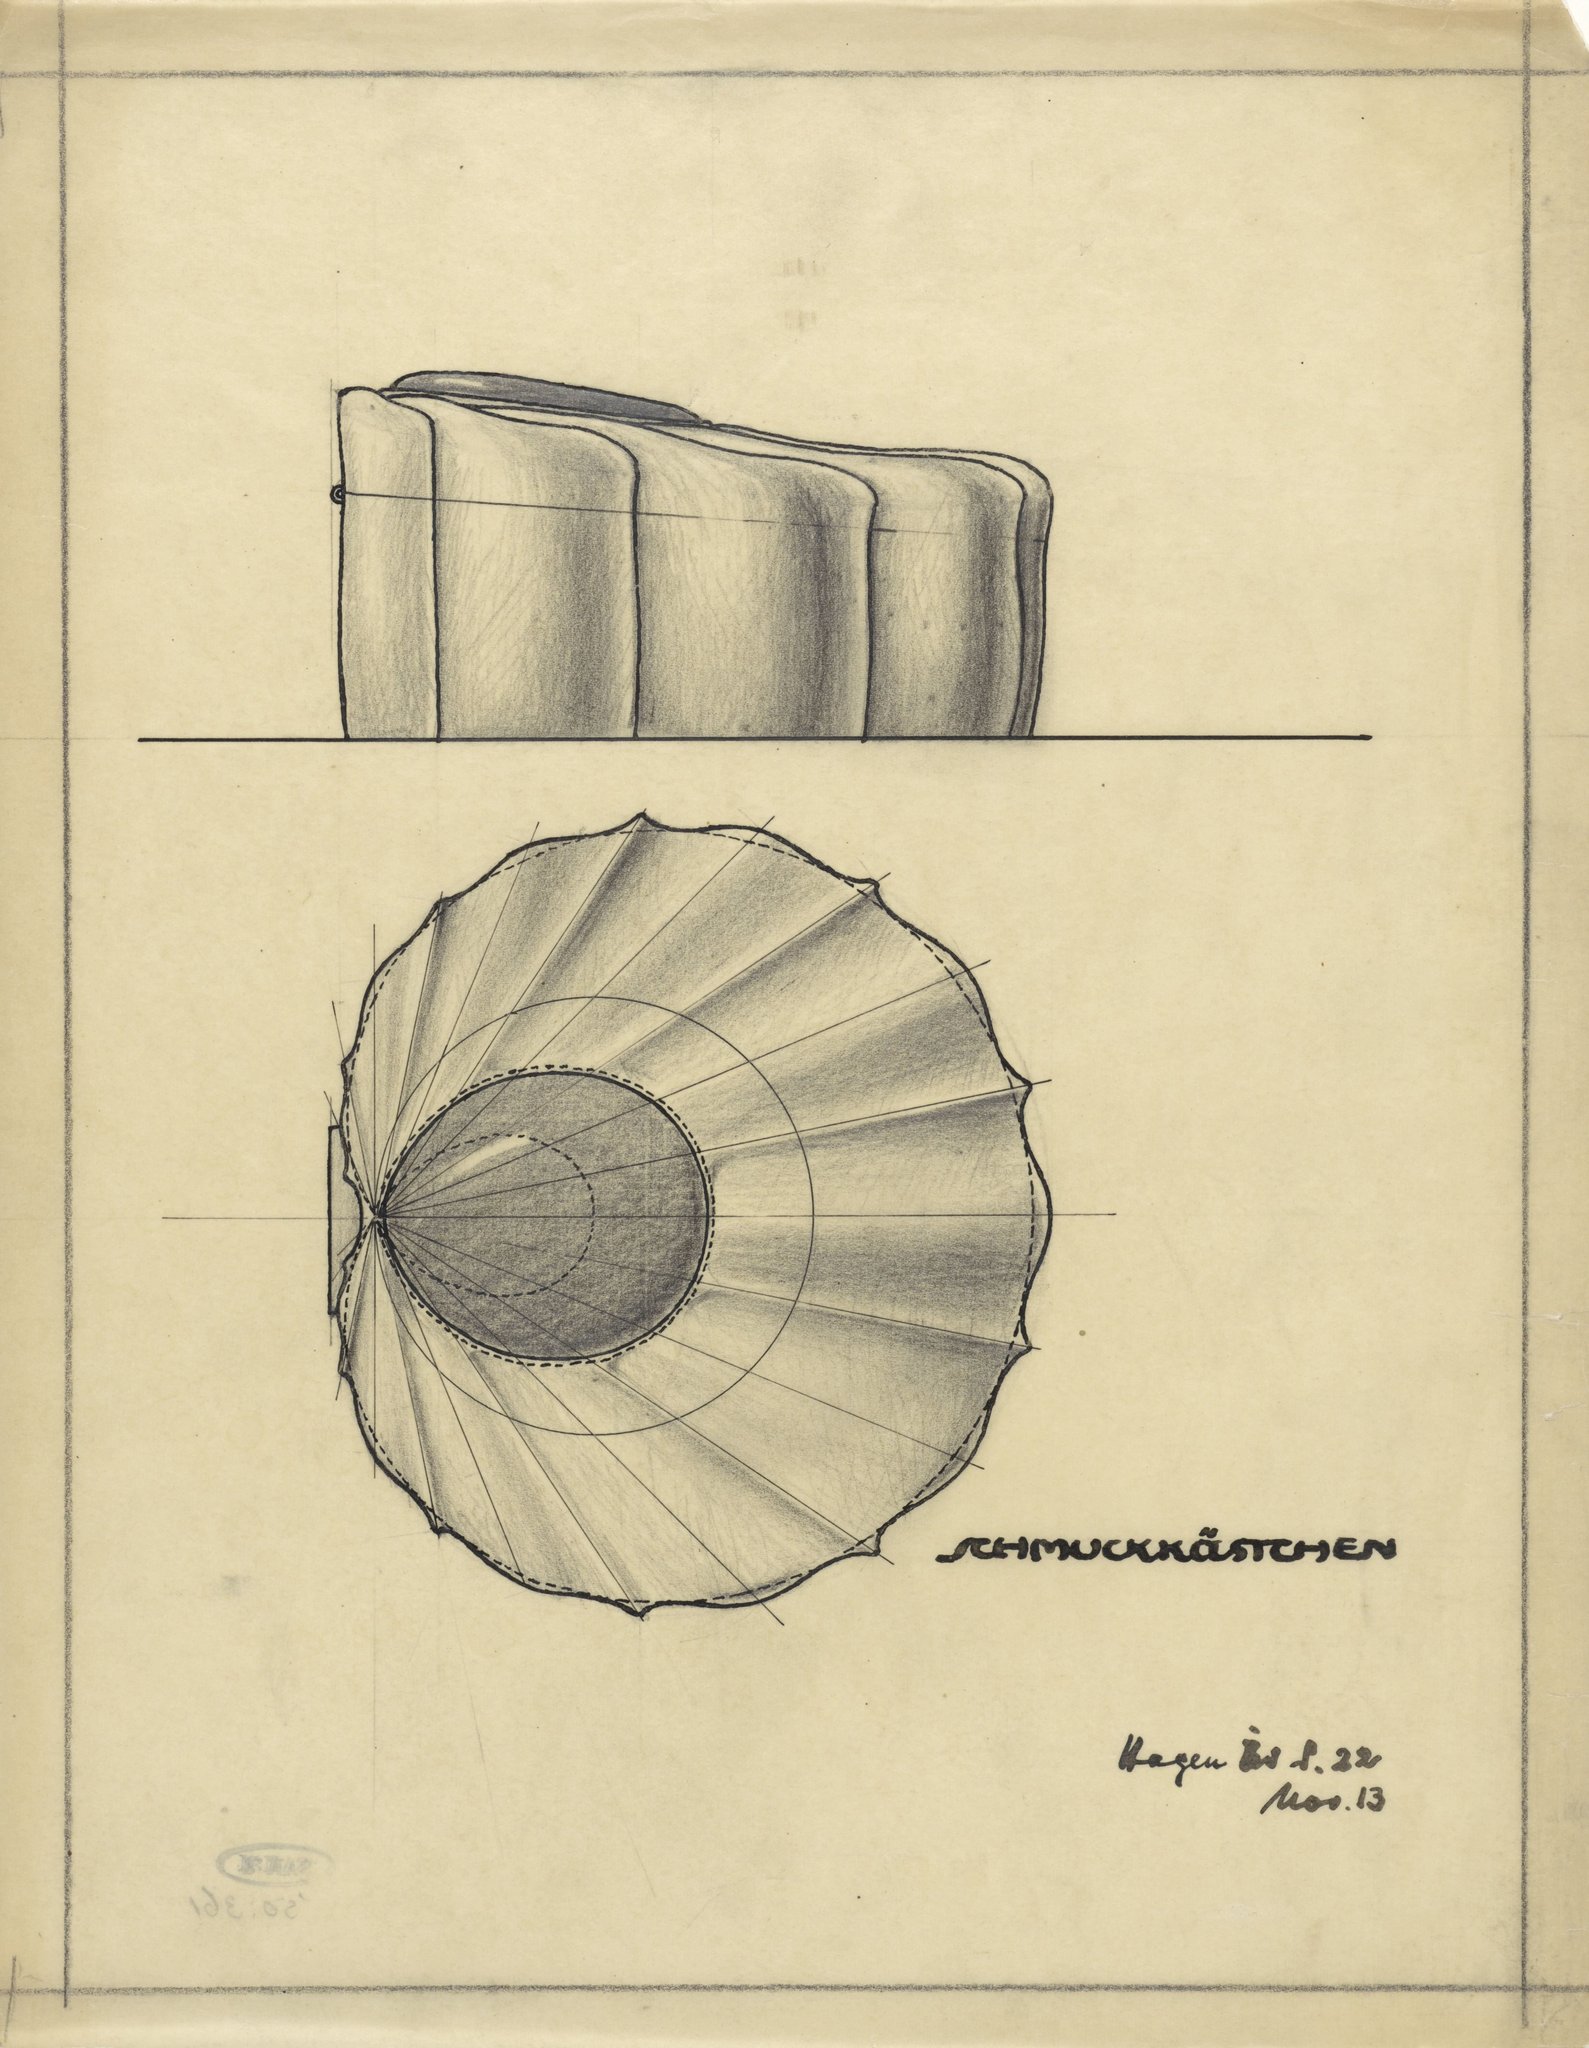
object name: drawing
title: Ontwerpen voor een juwelenkist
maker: mathieu lauweriks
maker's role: designer, draughtsman, print maker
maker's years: 1864-1932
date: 1911-1913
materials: ink, pencil, paper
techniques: pen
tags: jewel-box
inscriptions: date: ‘nov. 13’